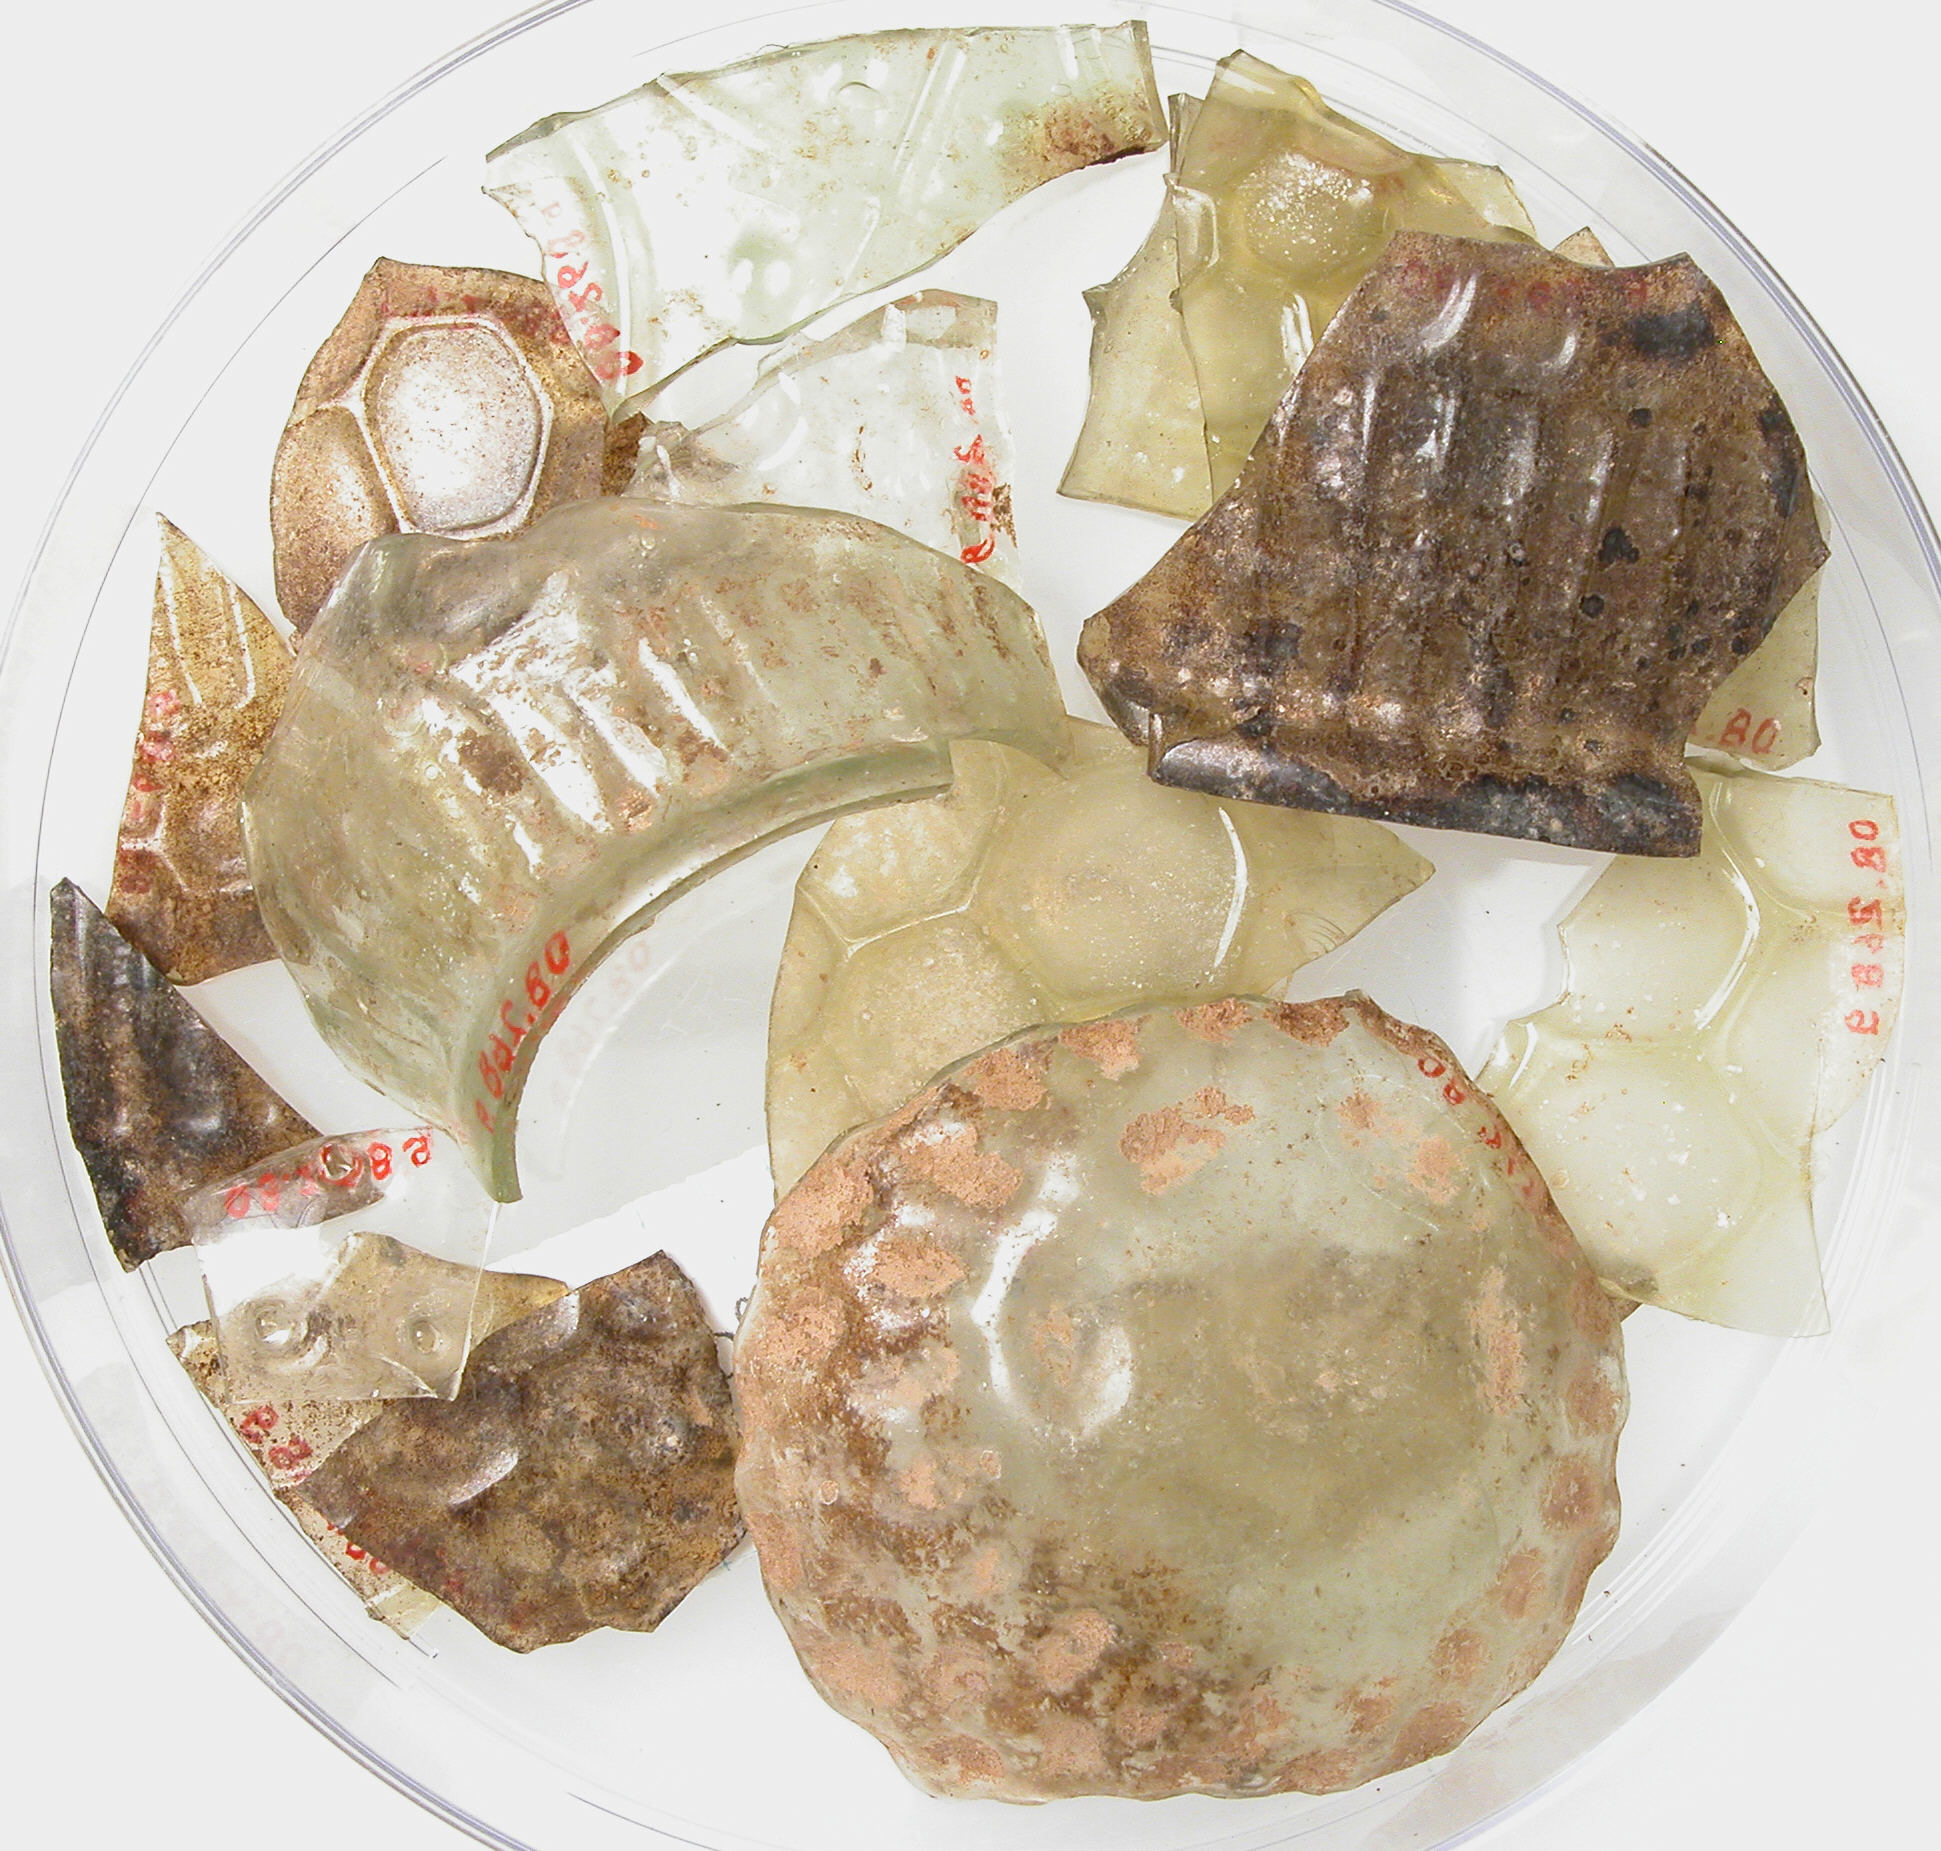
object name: fragment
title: Glass Fragments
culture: coptic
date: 301-433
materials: glass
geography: egypt